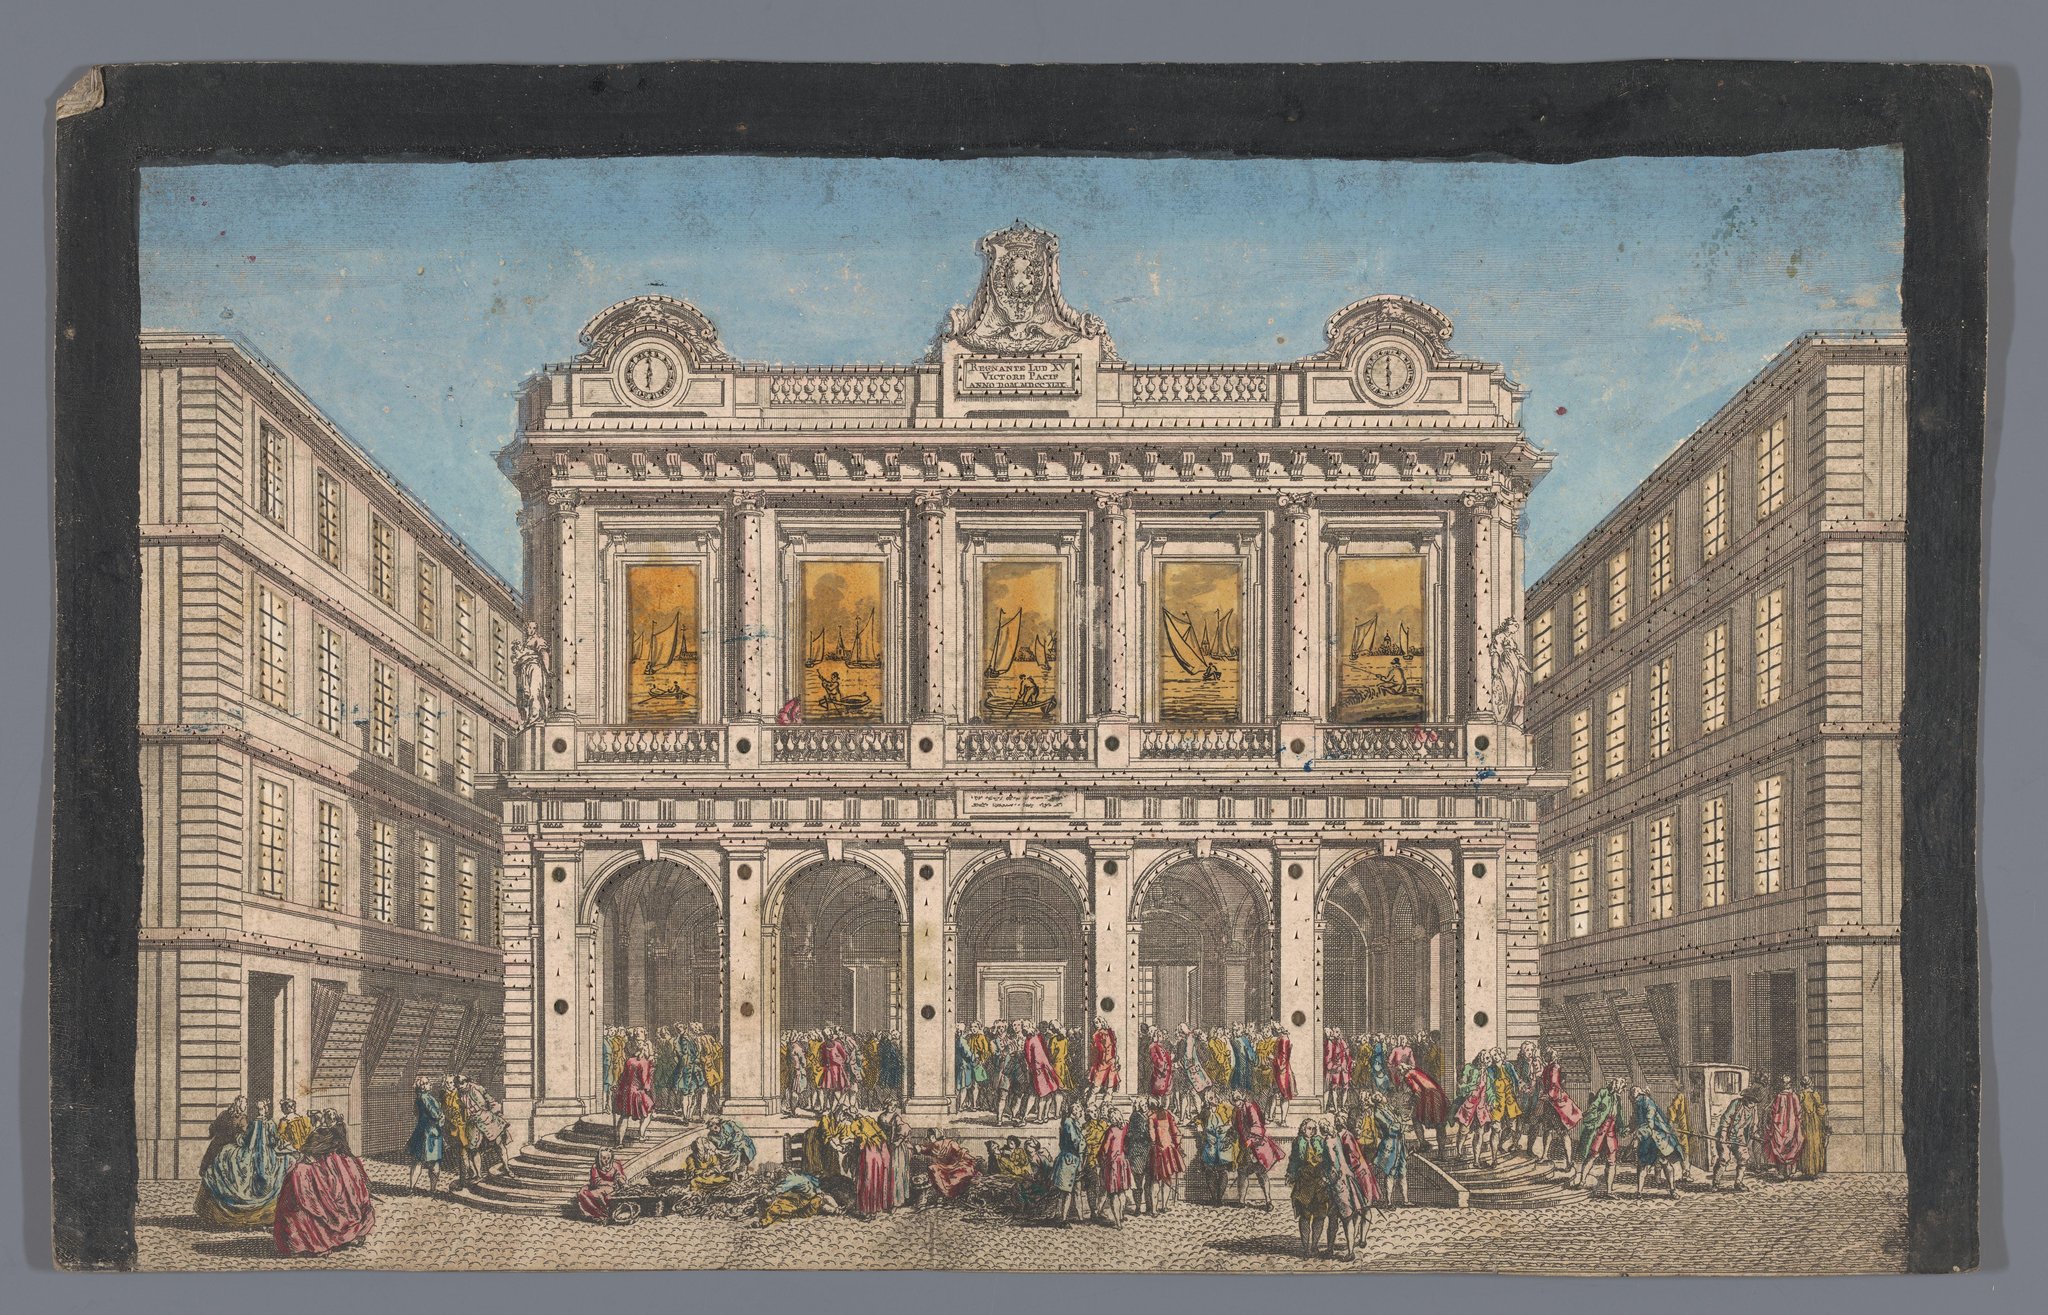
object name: print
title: Bourse ou Loge des Changes a Lyon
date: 1745-1775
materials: cardboard, paint, paper, watercolor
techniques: brush, cutting, etching, perforating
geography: france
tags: stock exchange, stock-market, square, place, circus, etc. (+ city(-scape) with figures, staffage), stock exchange of lyon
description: In de prent is een aantal delen weggesneden waar vervolgens met penseel is getekend.